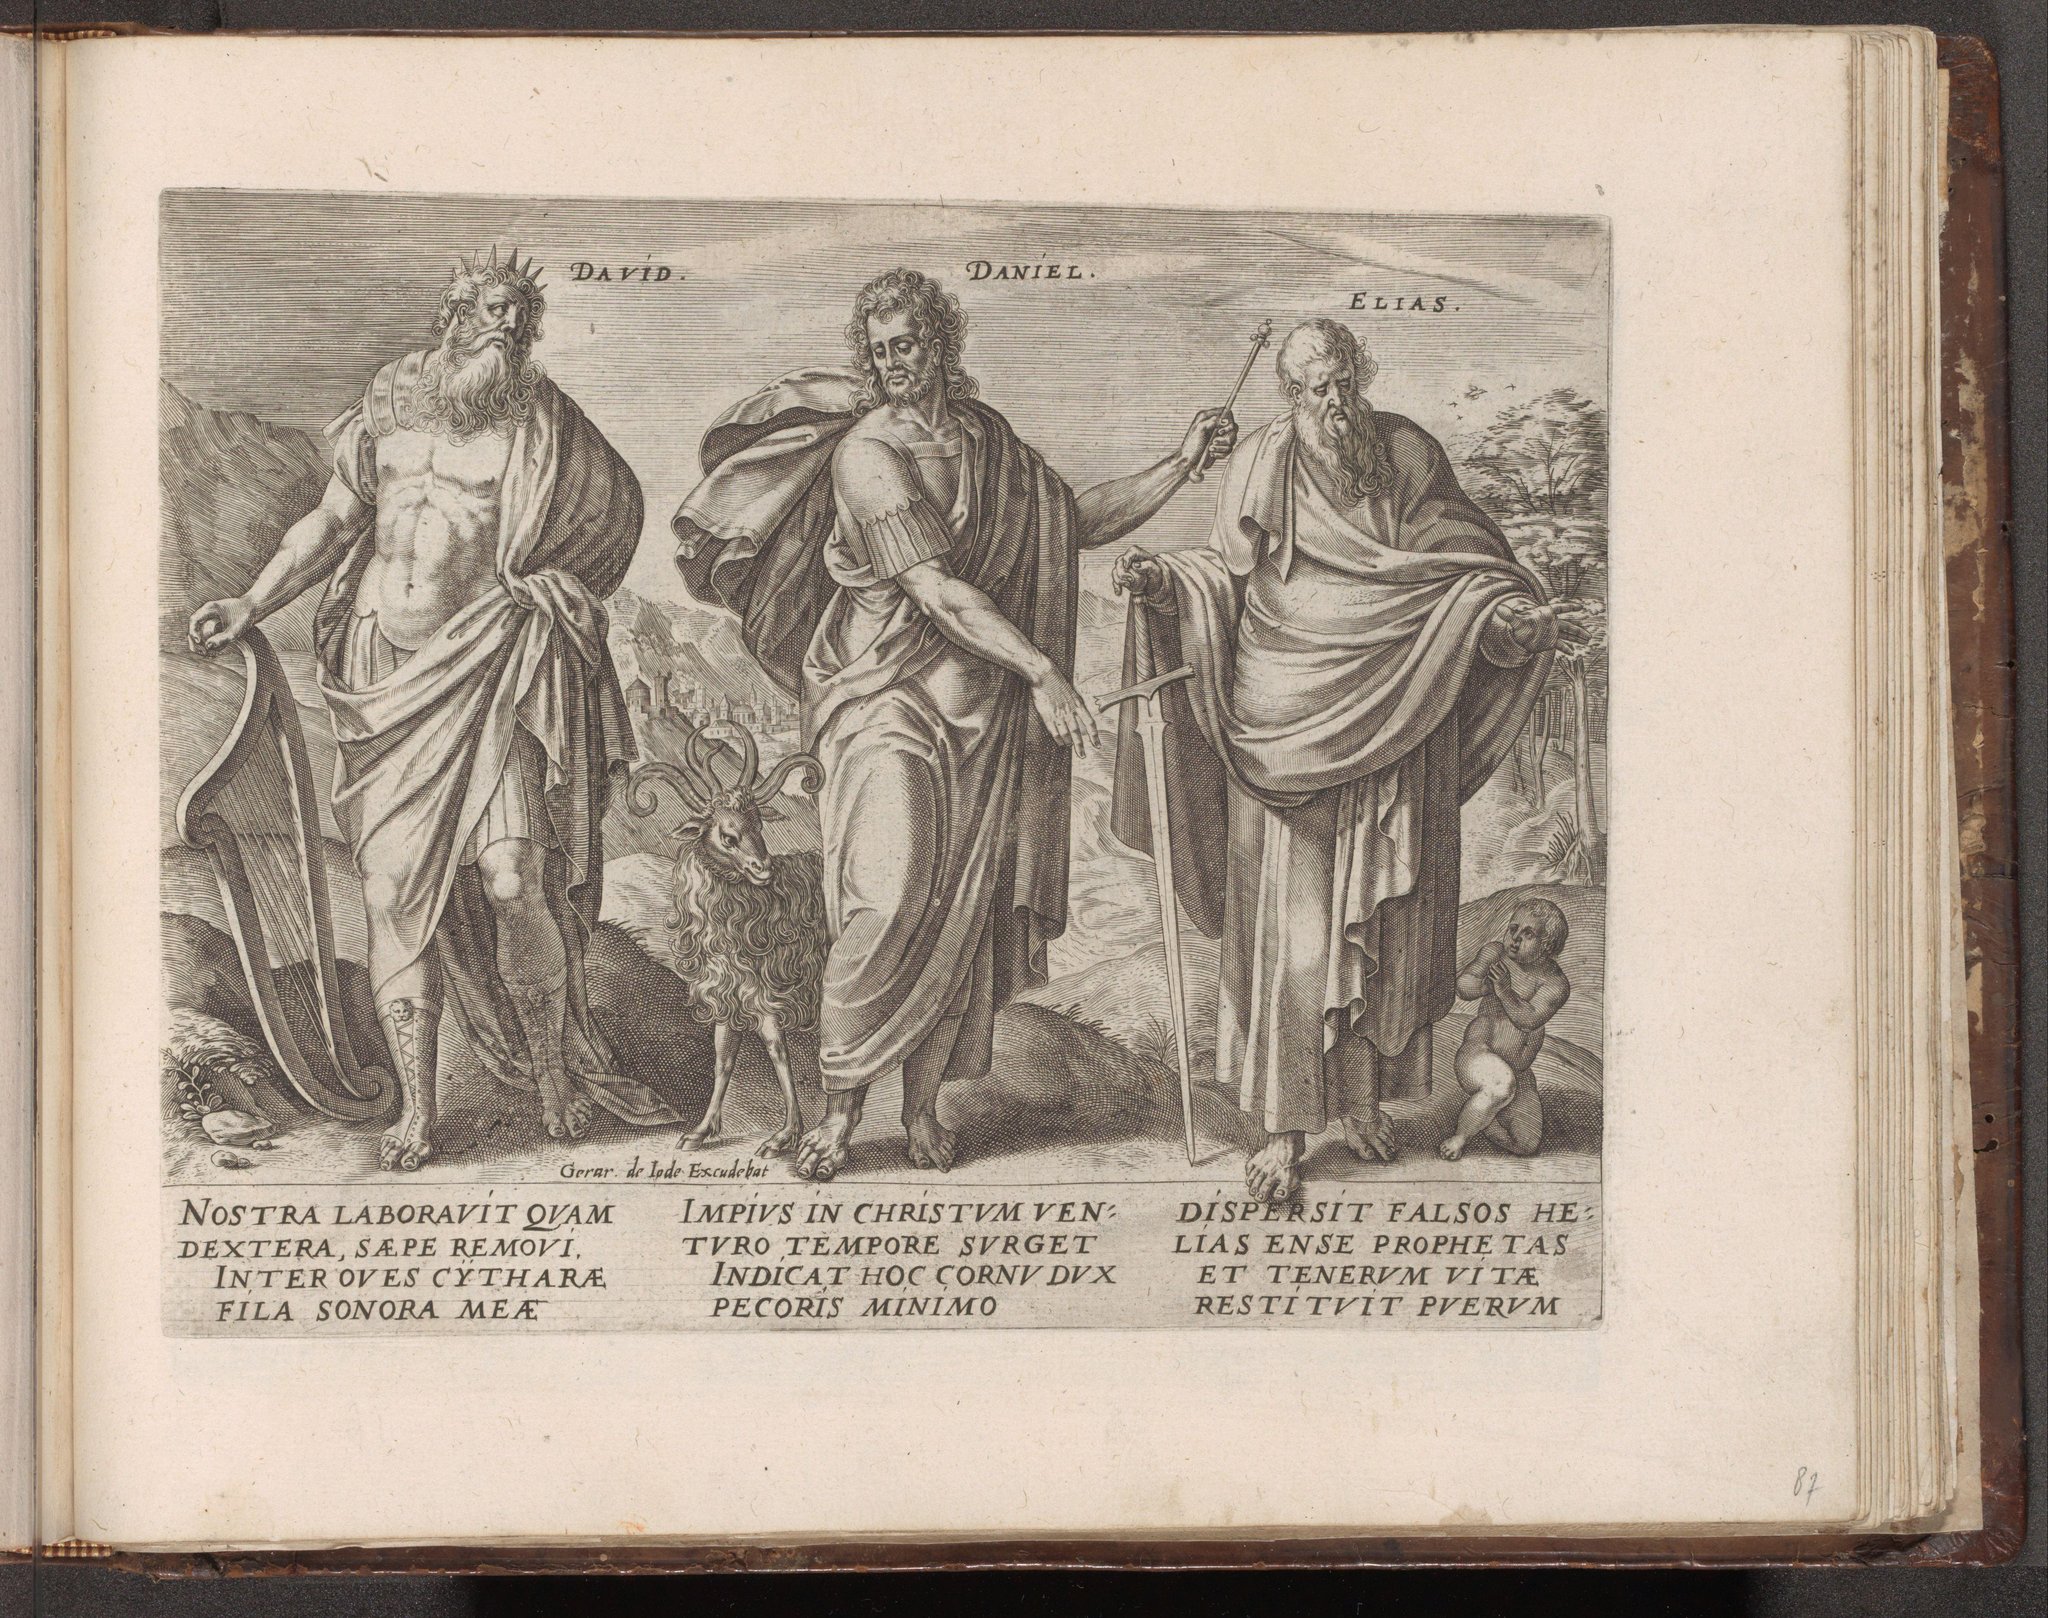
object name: album leaf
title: Twaalf profeten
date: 1579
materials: paper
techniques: engraving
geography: antwerp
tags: daniel (not in biblical context); possible attributes: phrygian bonnet, lion(s), ram - other activities, relationships, etc. of male persons from the old testament, david as prophet, with crown and scroll, groups of prophets, usually holding books or scrolls (isaiah, jeremiah, ezekiel, daniel, hosea, joel, amos, obadiah, jonah, micah, nahum, habakkuk, zephaniah, haggai, zechariah, malachi), elijah (not in biblical context); possible attributes: scroll and flaming sword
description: De profeten David, Daniël en Elia staan naast elkaar in een landschap. Koning David met kroon en harp, Daniël met staf en naast hem een bok, Elia met zwaard en een knielend kind naast zich. Onder de voorstelling toelichtingen in het Latijn. Prent maakt deel uit van een album.